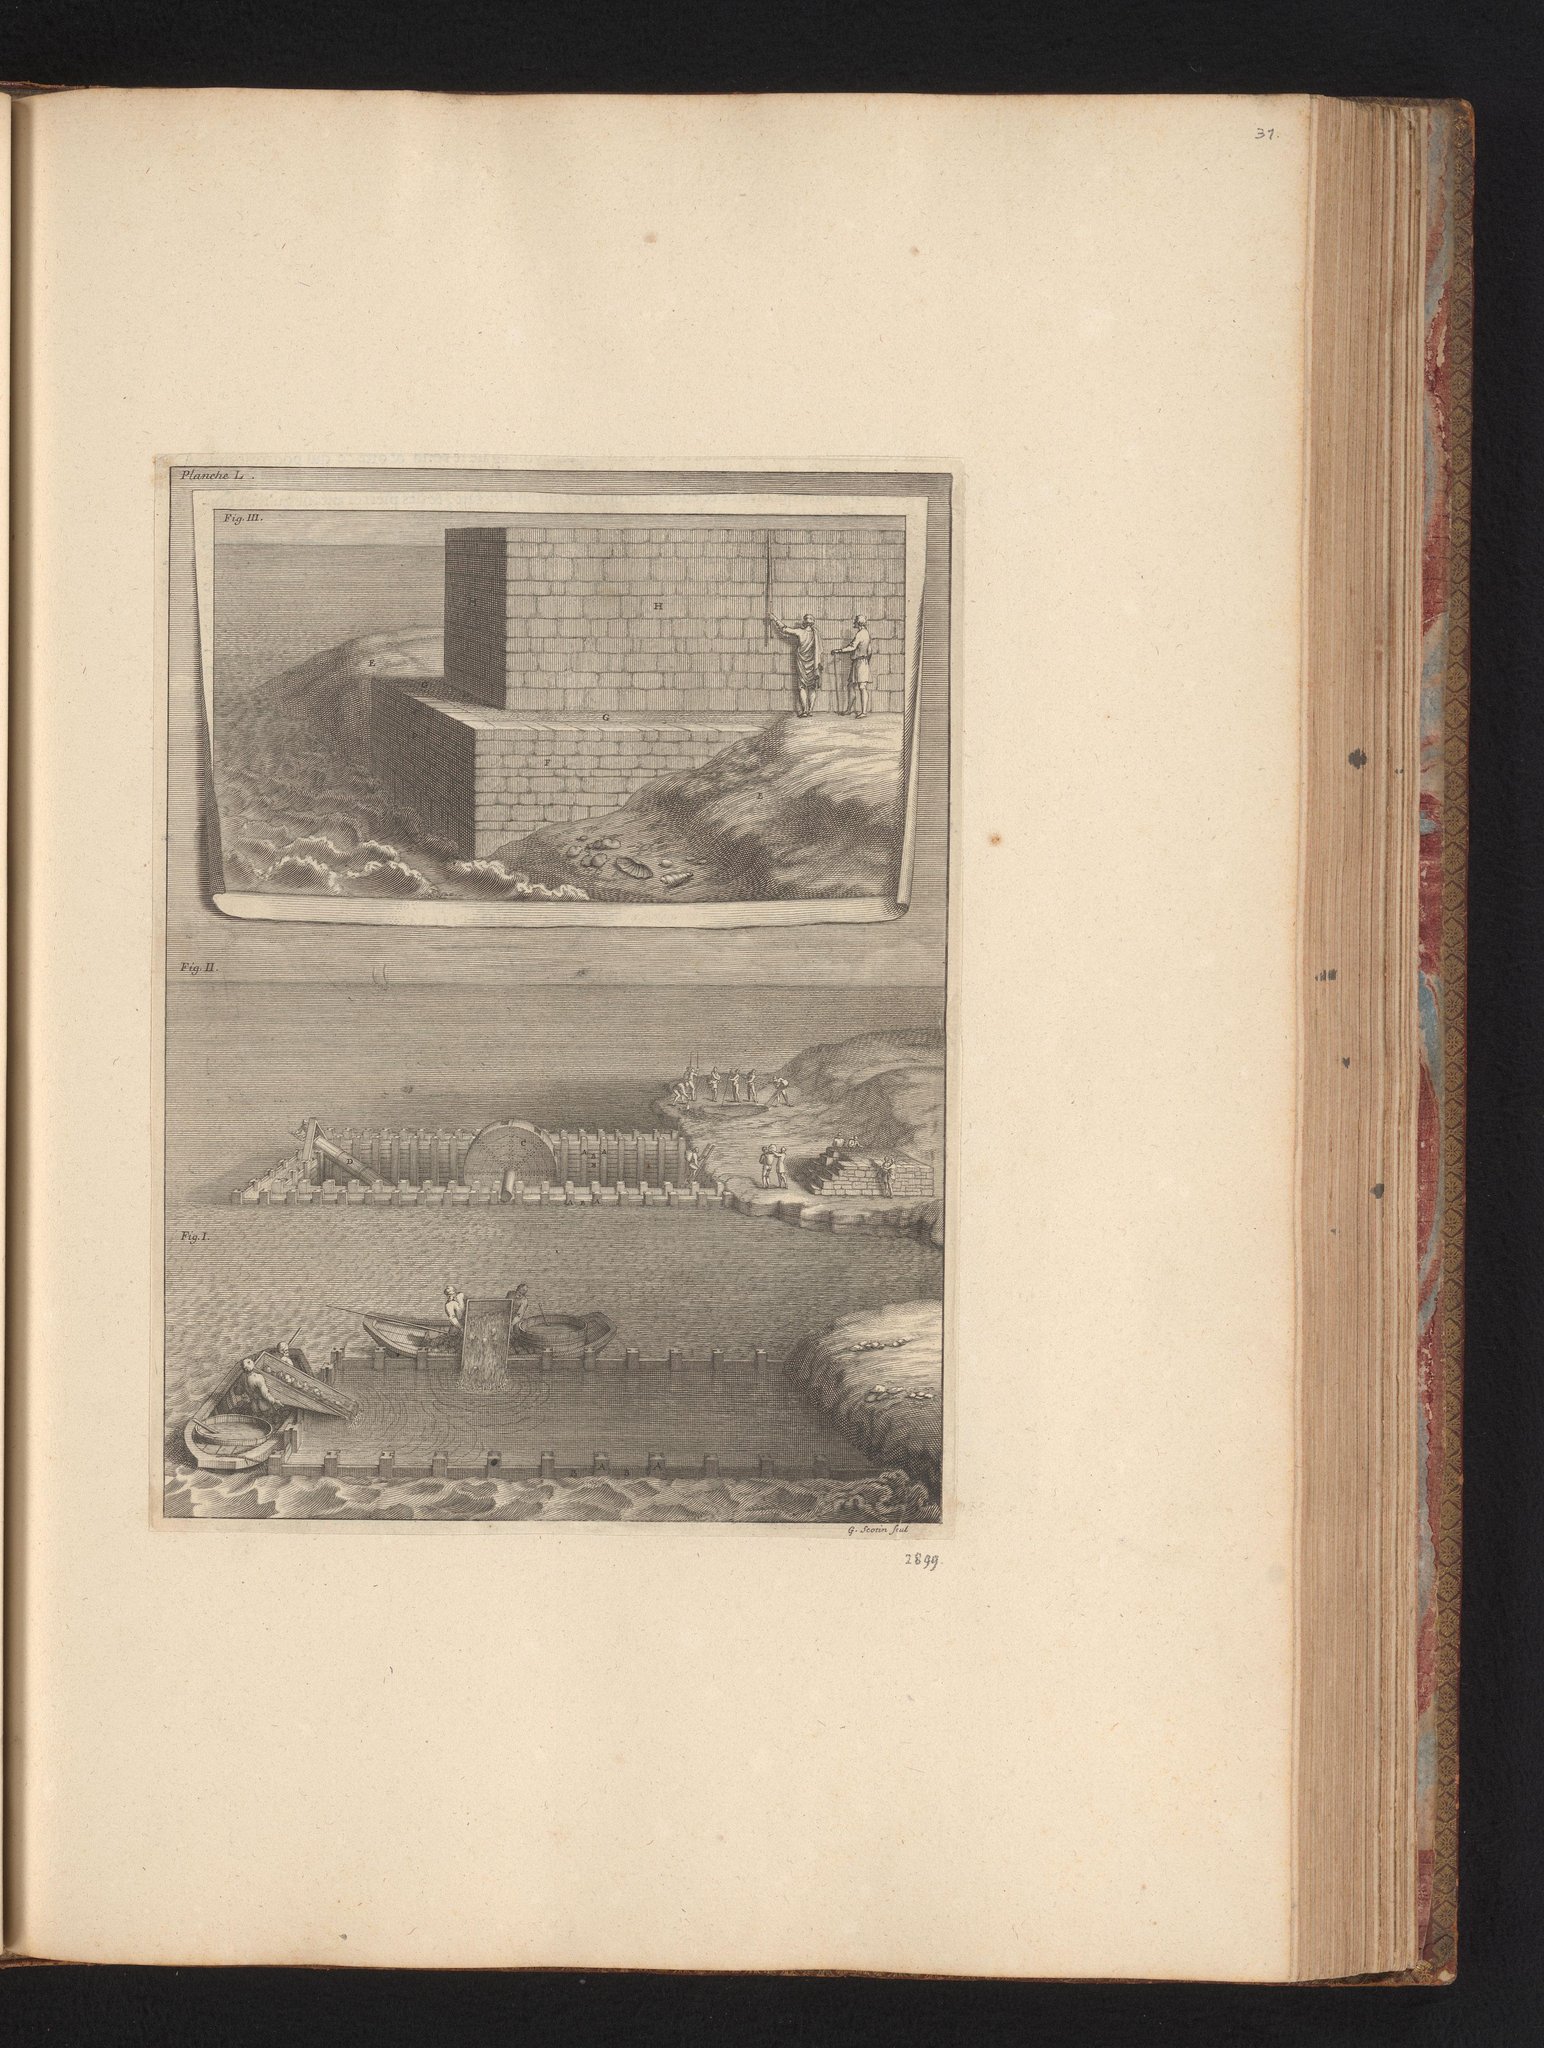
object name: print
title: Drie manieren om een steiger in zee te maken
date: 1673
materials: paper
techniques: engraving, etching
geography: paris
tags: building activities, pier, quay, wharf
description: Prent uit: Perrault, Claude. Les dix livres d'architecture de Vitruve. Parijs: Jean-Baptiste Coignard, 1673.